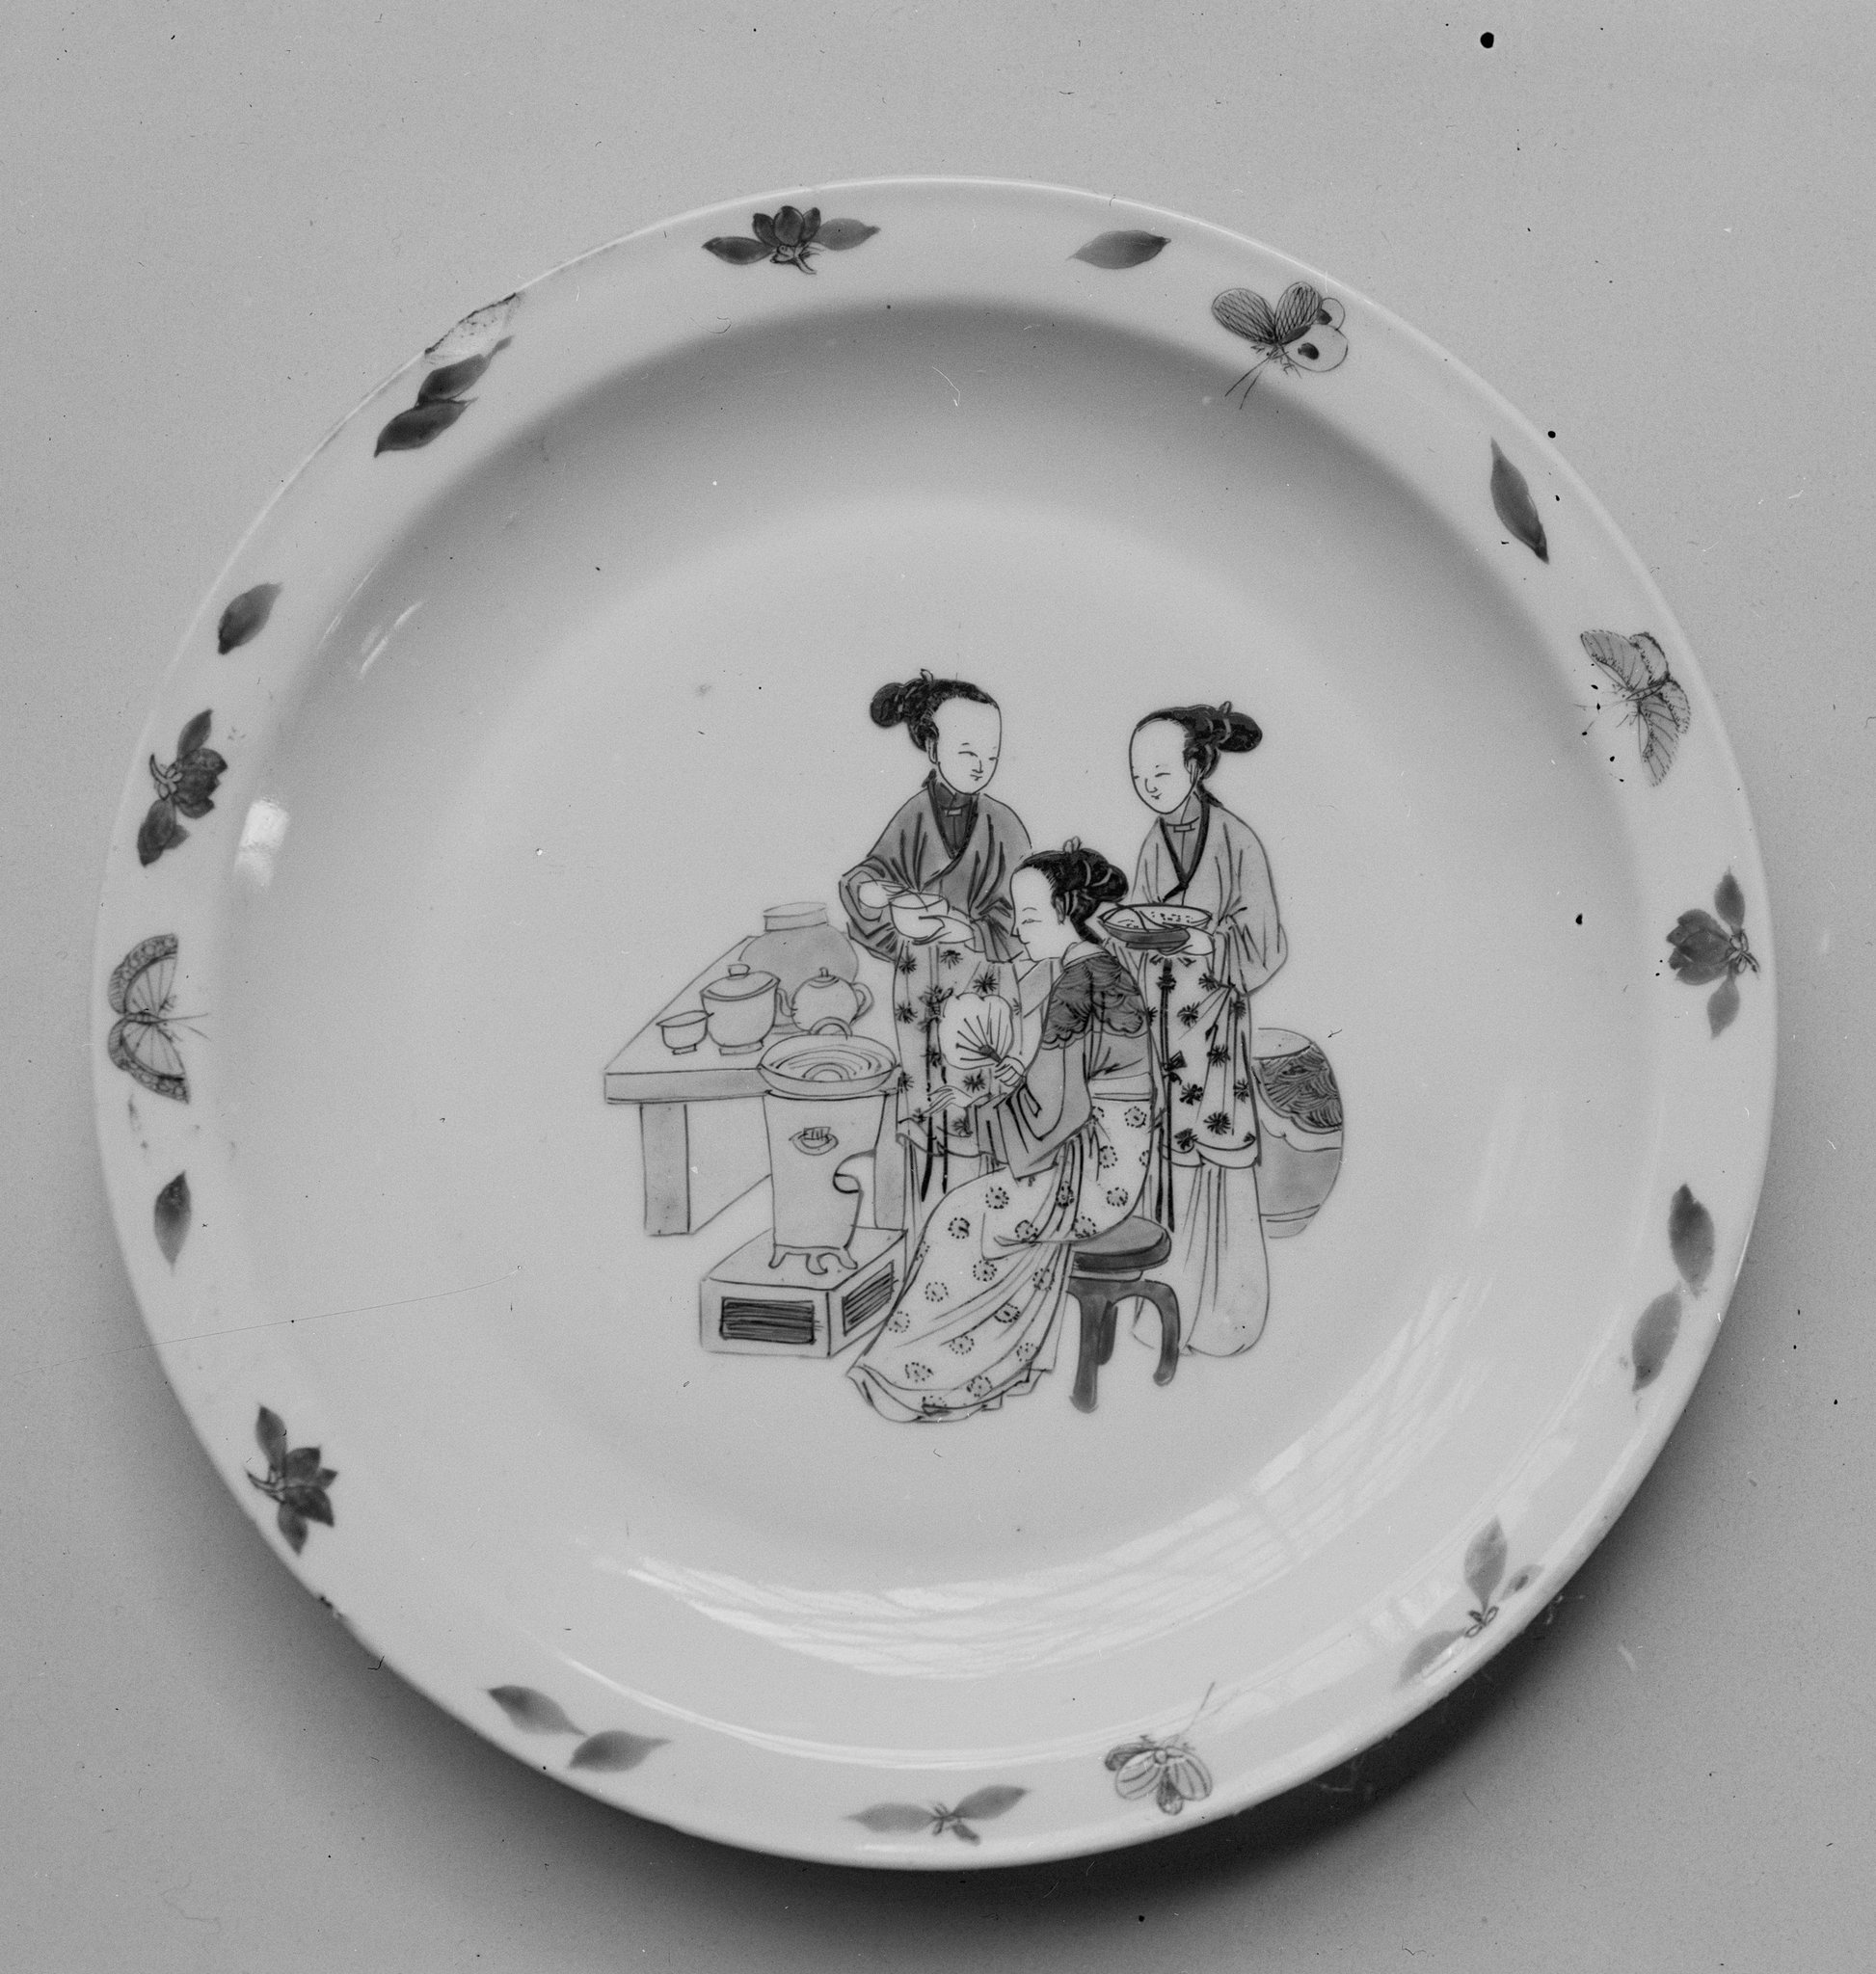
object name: plate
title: Plate with women cooking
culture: chinese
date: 1662-1722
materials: enamel, porcelain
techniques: overglaze, painting, polychrome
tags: women,cooking